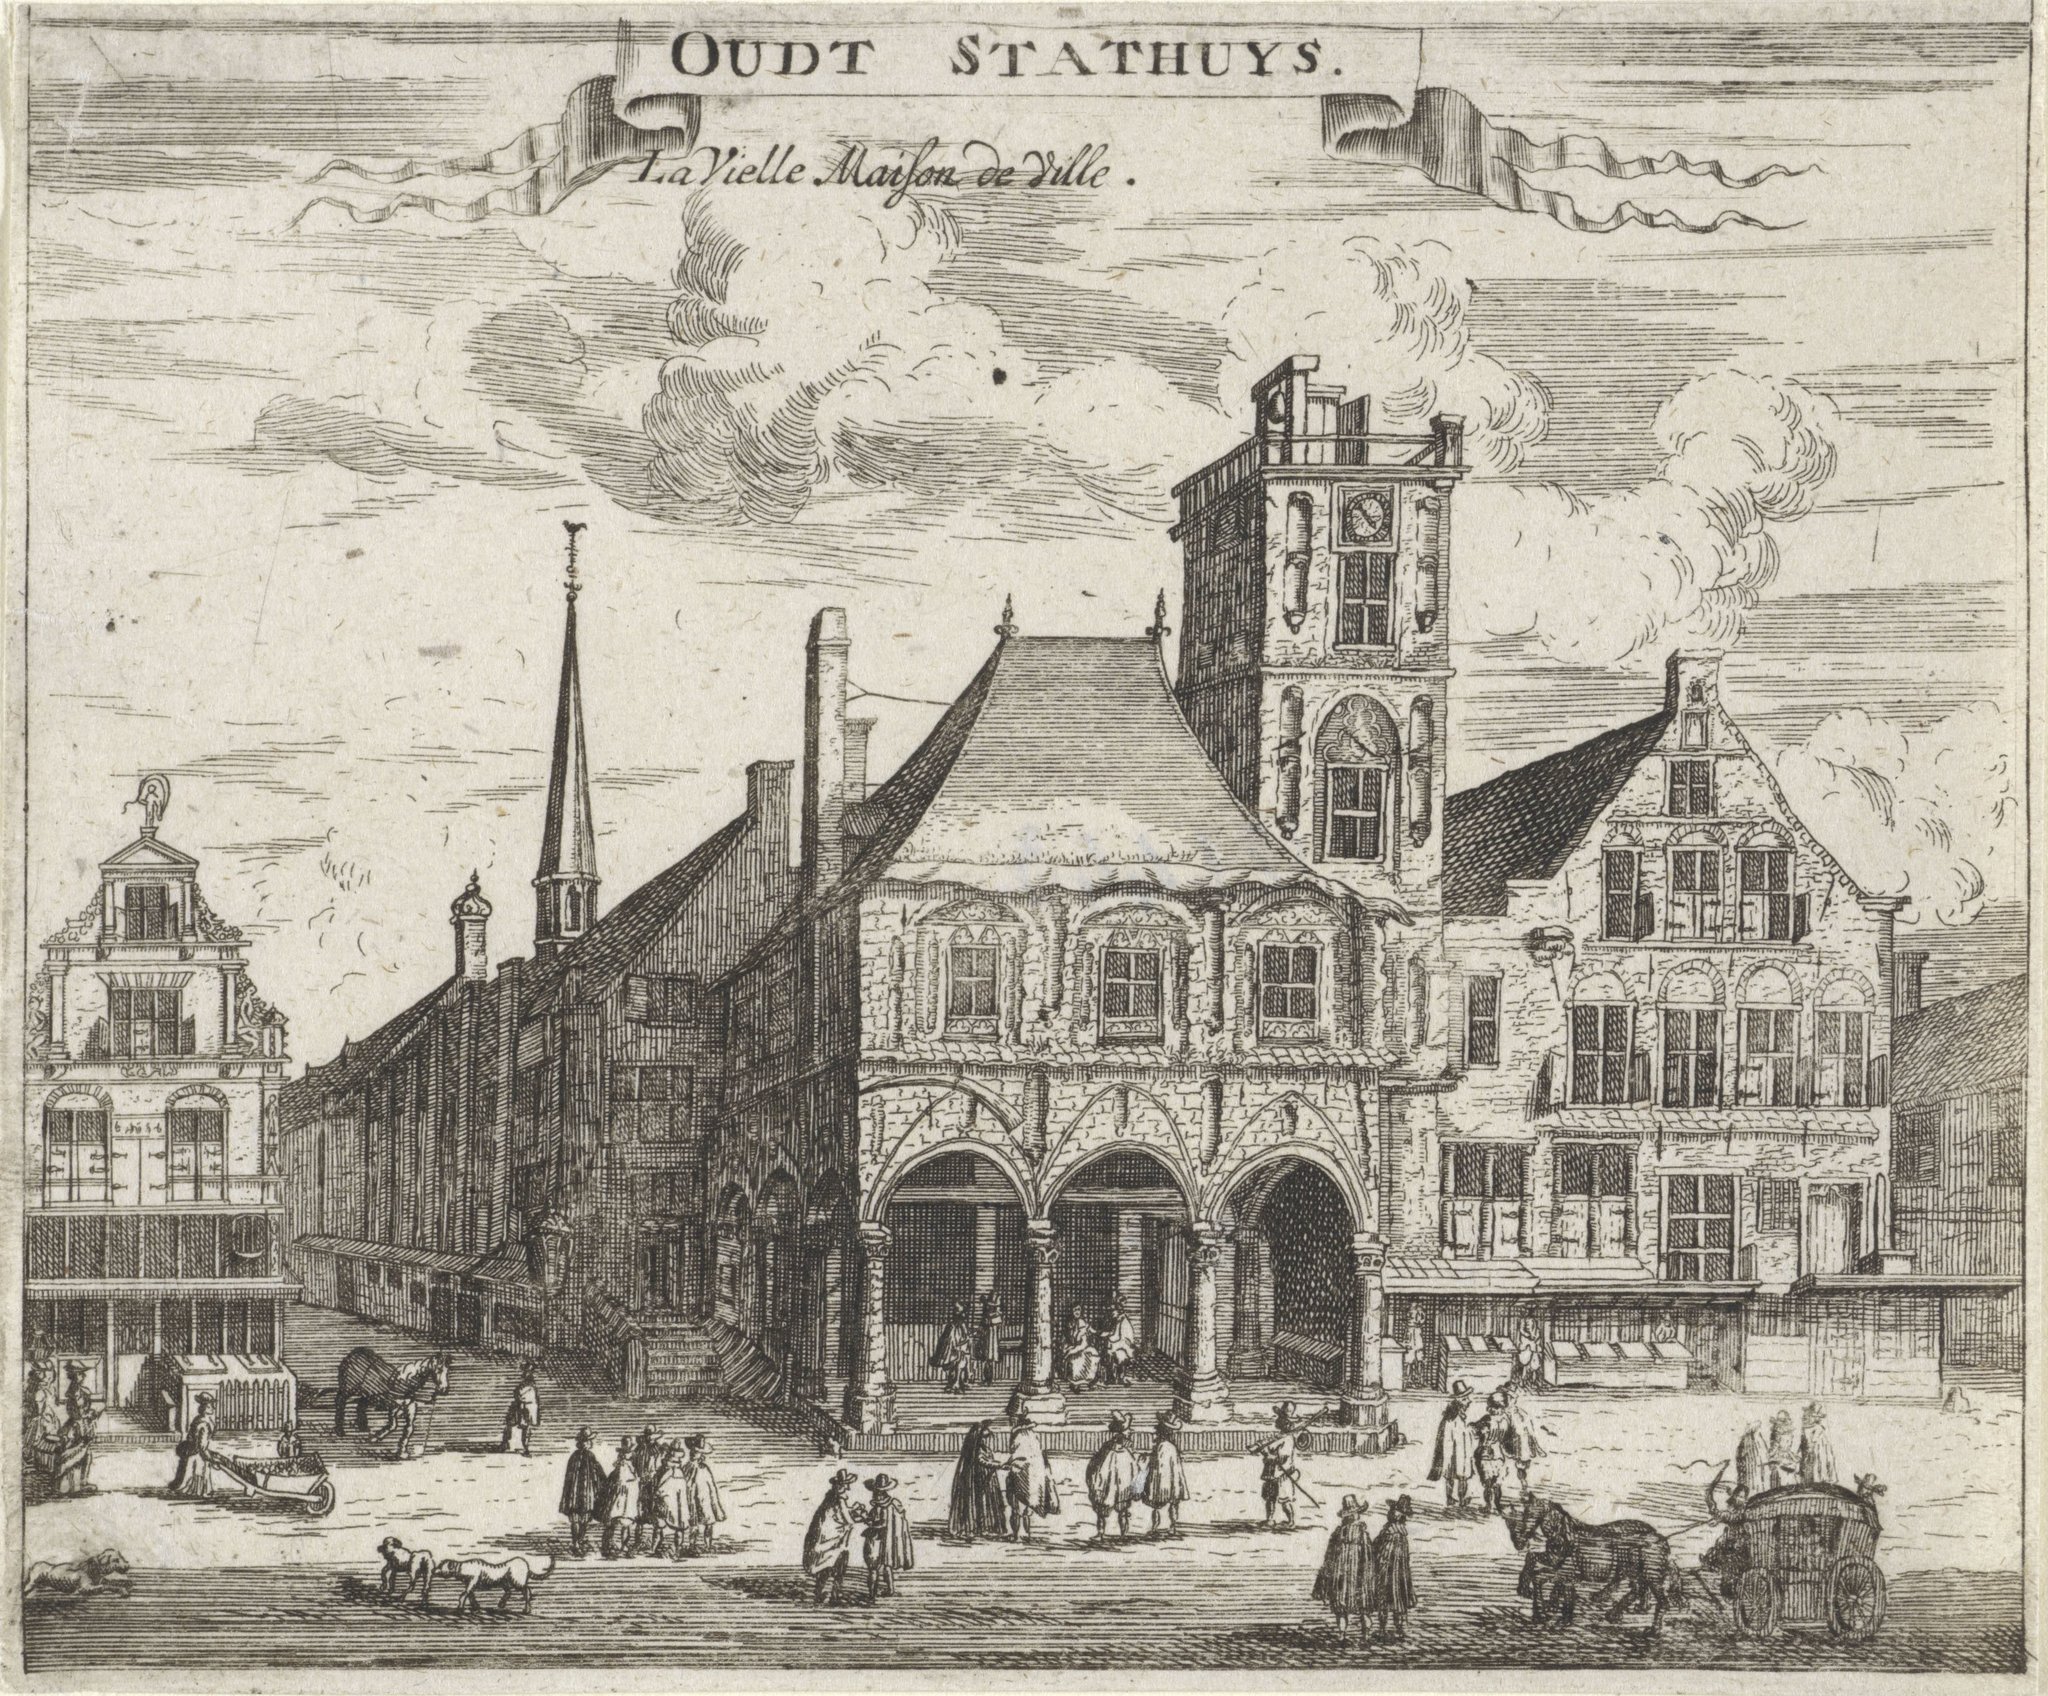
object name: print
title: Gezicht op het Oude Stadhuis te Amsterdam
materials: paper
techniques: engraving, etching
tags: townhall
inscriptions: collector's mark: Lugt 2233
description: Gezicht op het Oude Stadhuis te Amsterdam op de westzijde van de Dam. Helemaal links het eerste huis van de Kalverstraat, rechts daarvan de Gasthuissteeg.